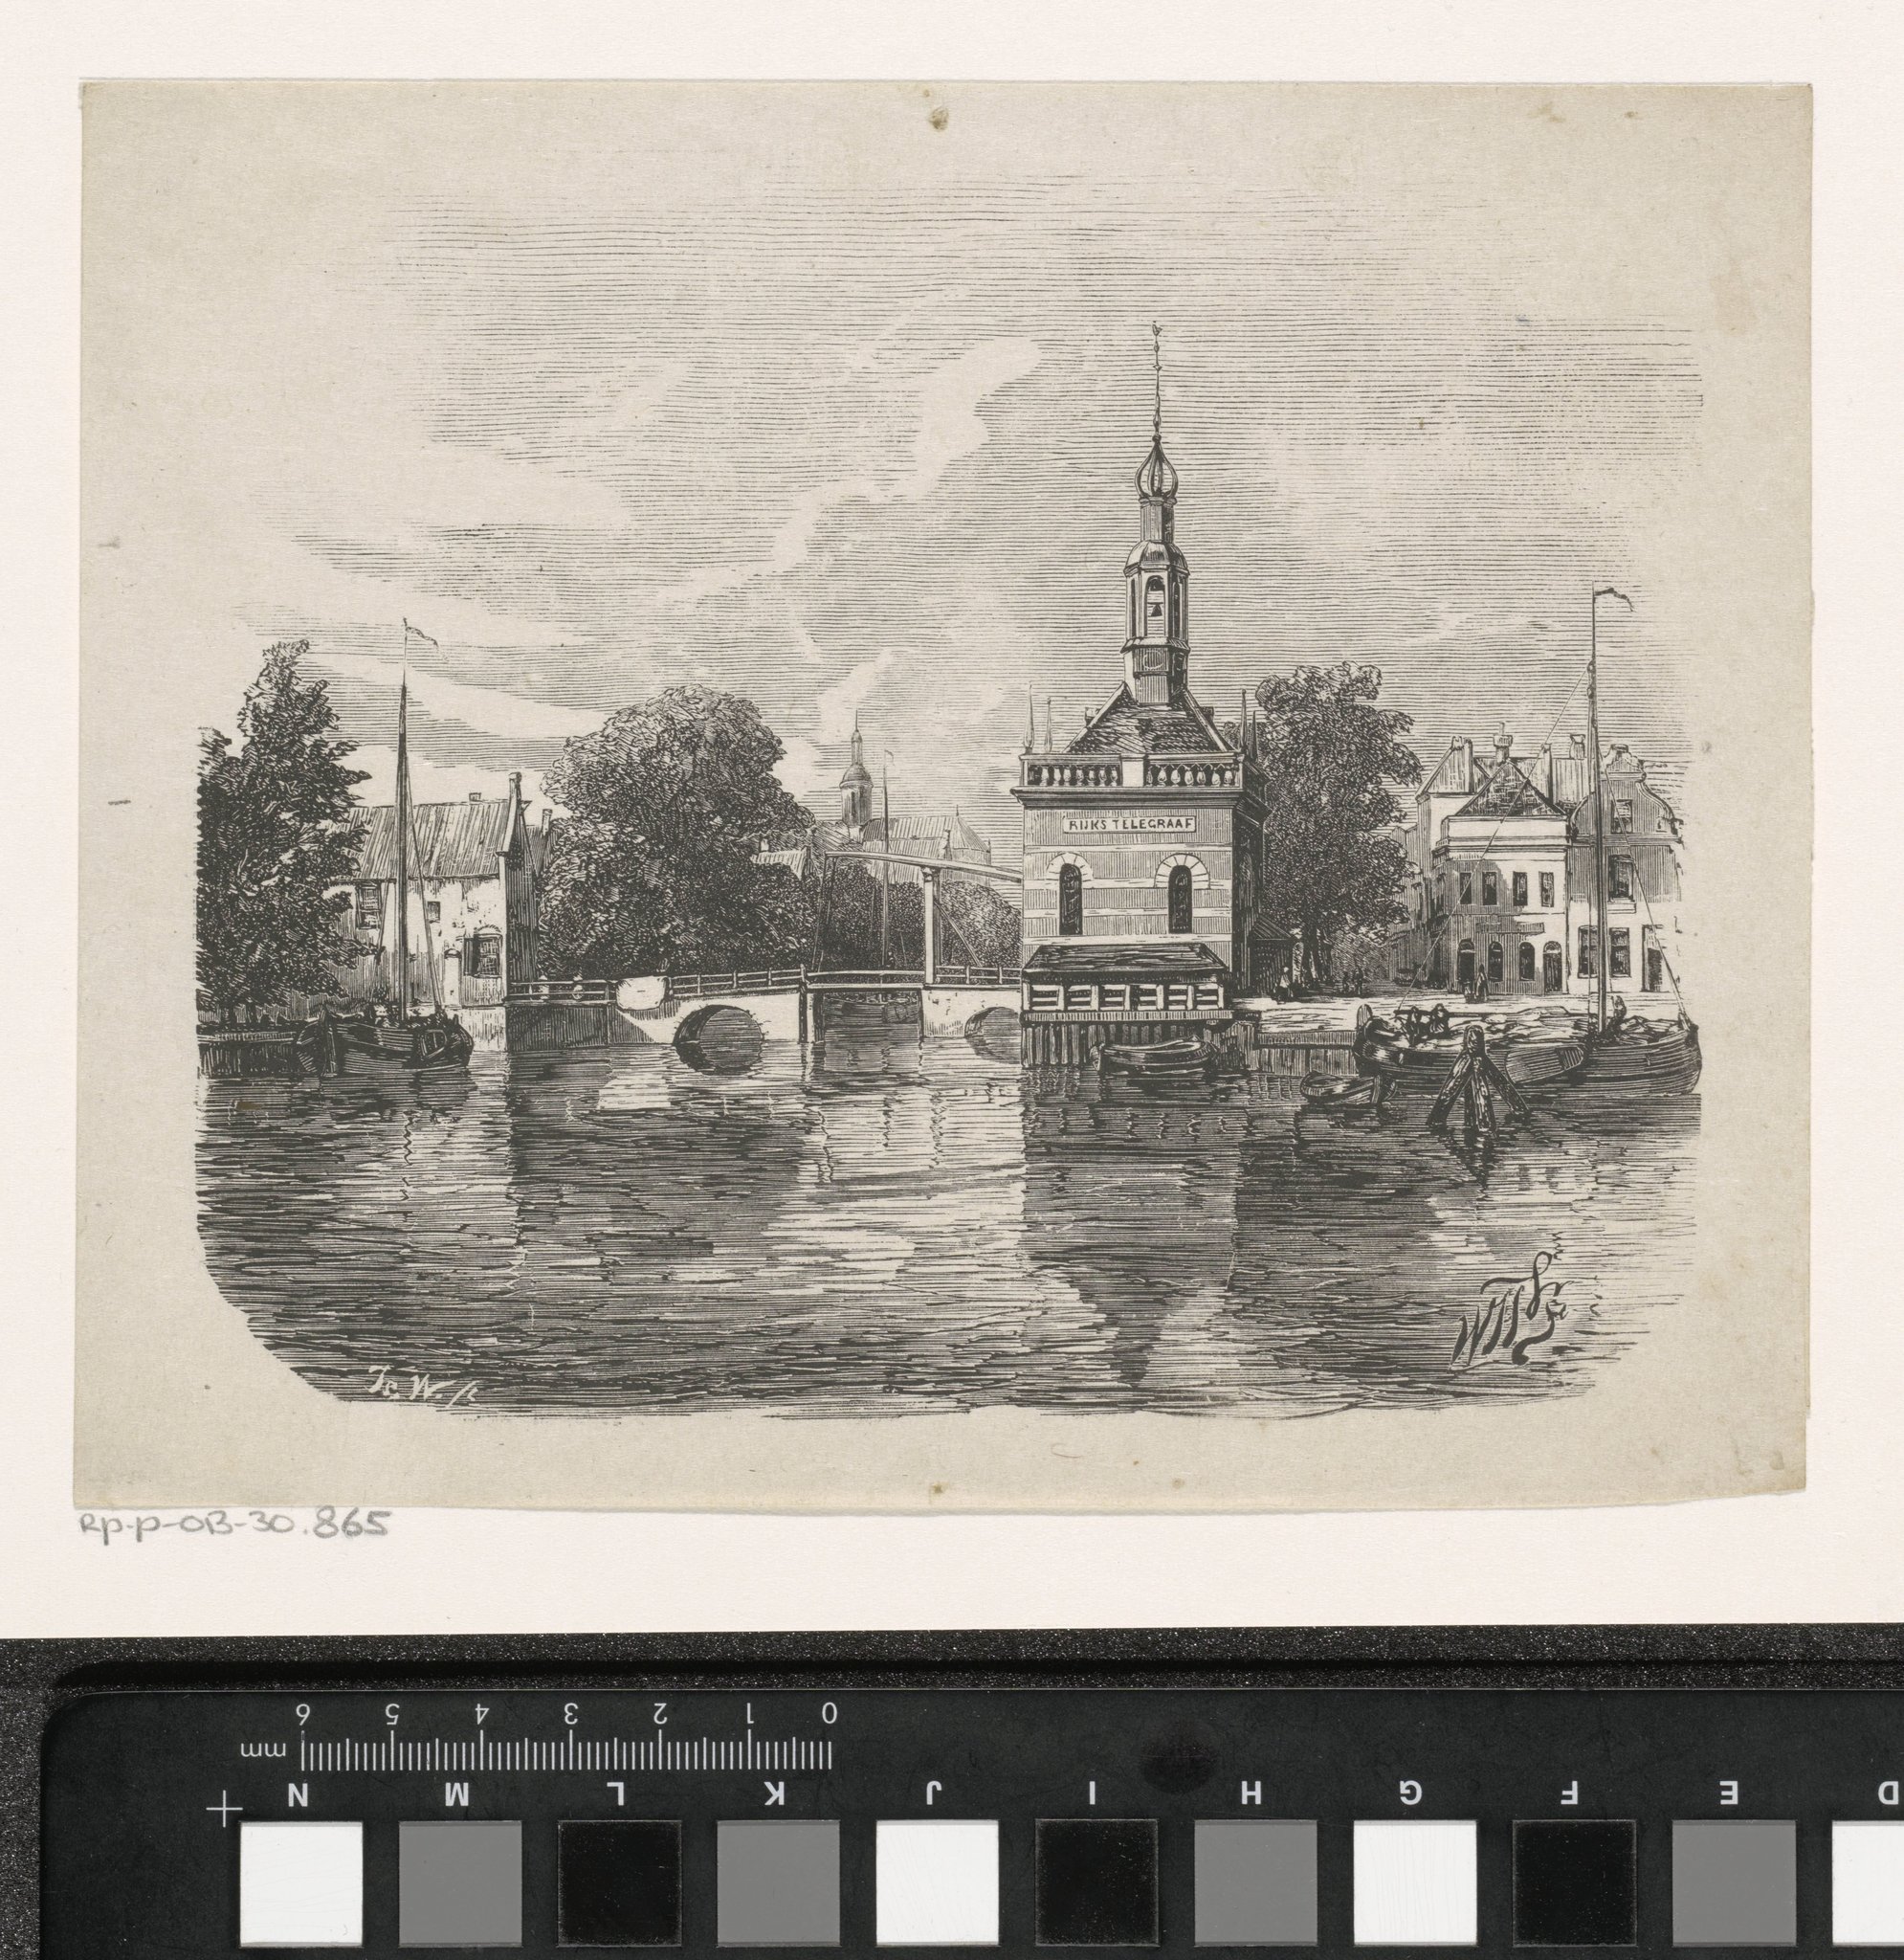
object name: print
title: Gezicht op het gebouw van de Rijkstelegraaf en een ophaalbrug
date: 1836-1912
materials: paper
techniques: engraving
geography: netherlands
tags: drawbridge ~ fortified city, post, telegraph and telephone; means of communication, ships (in general), civic architecture; edifices; dwellings